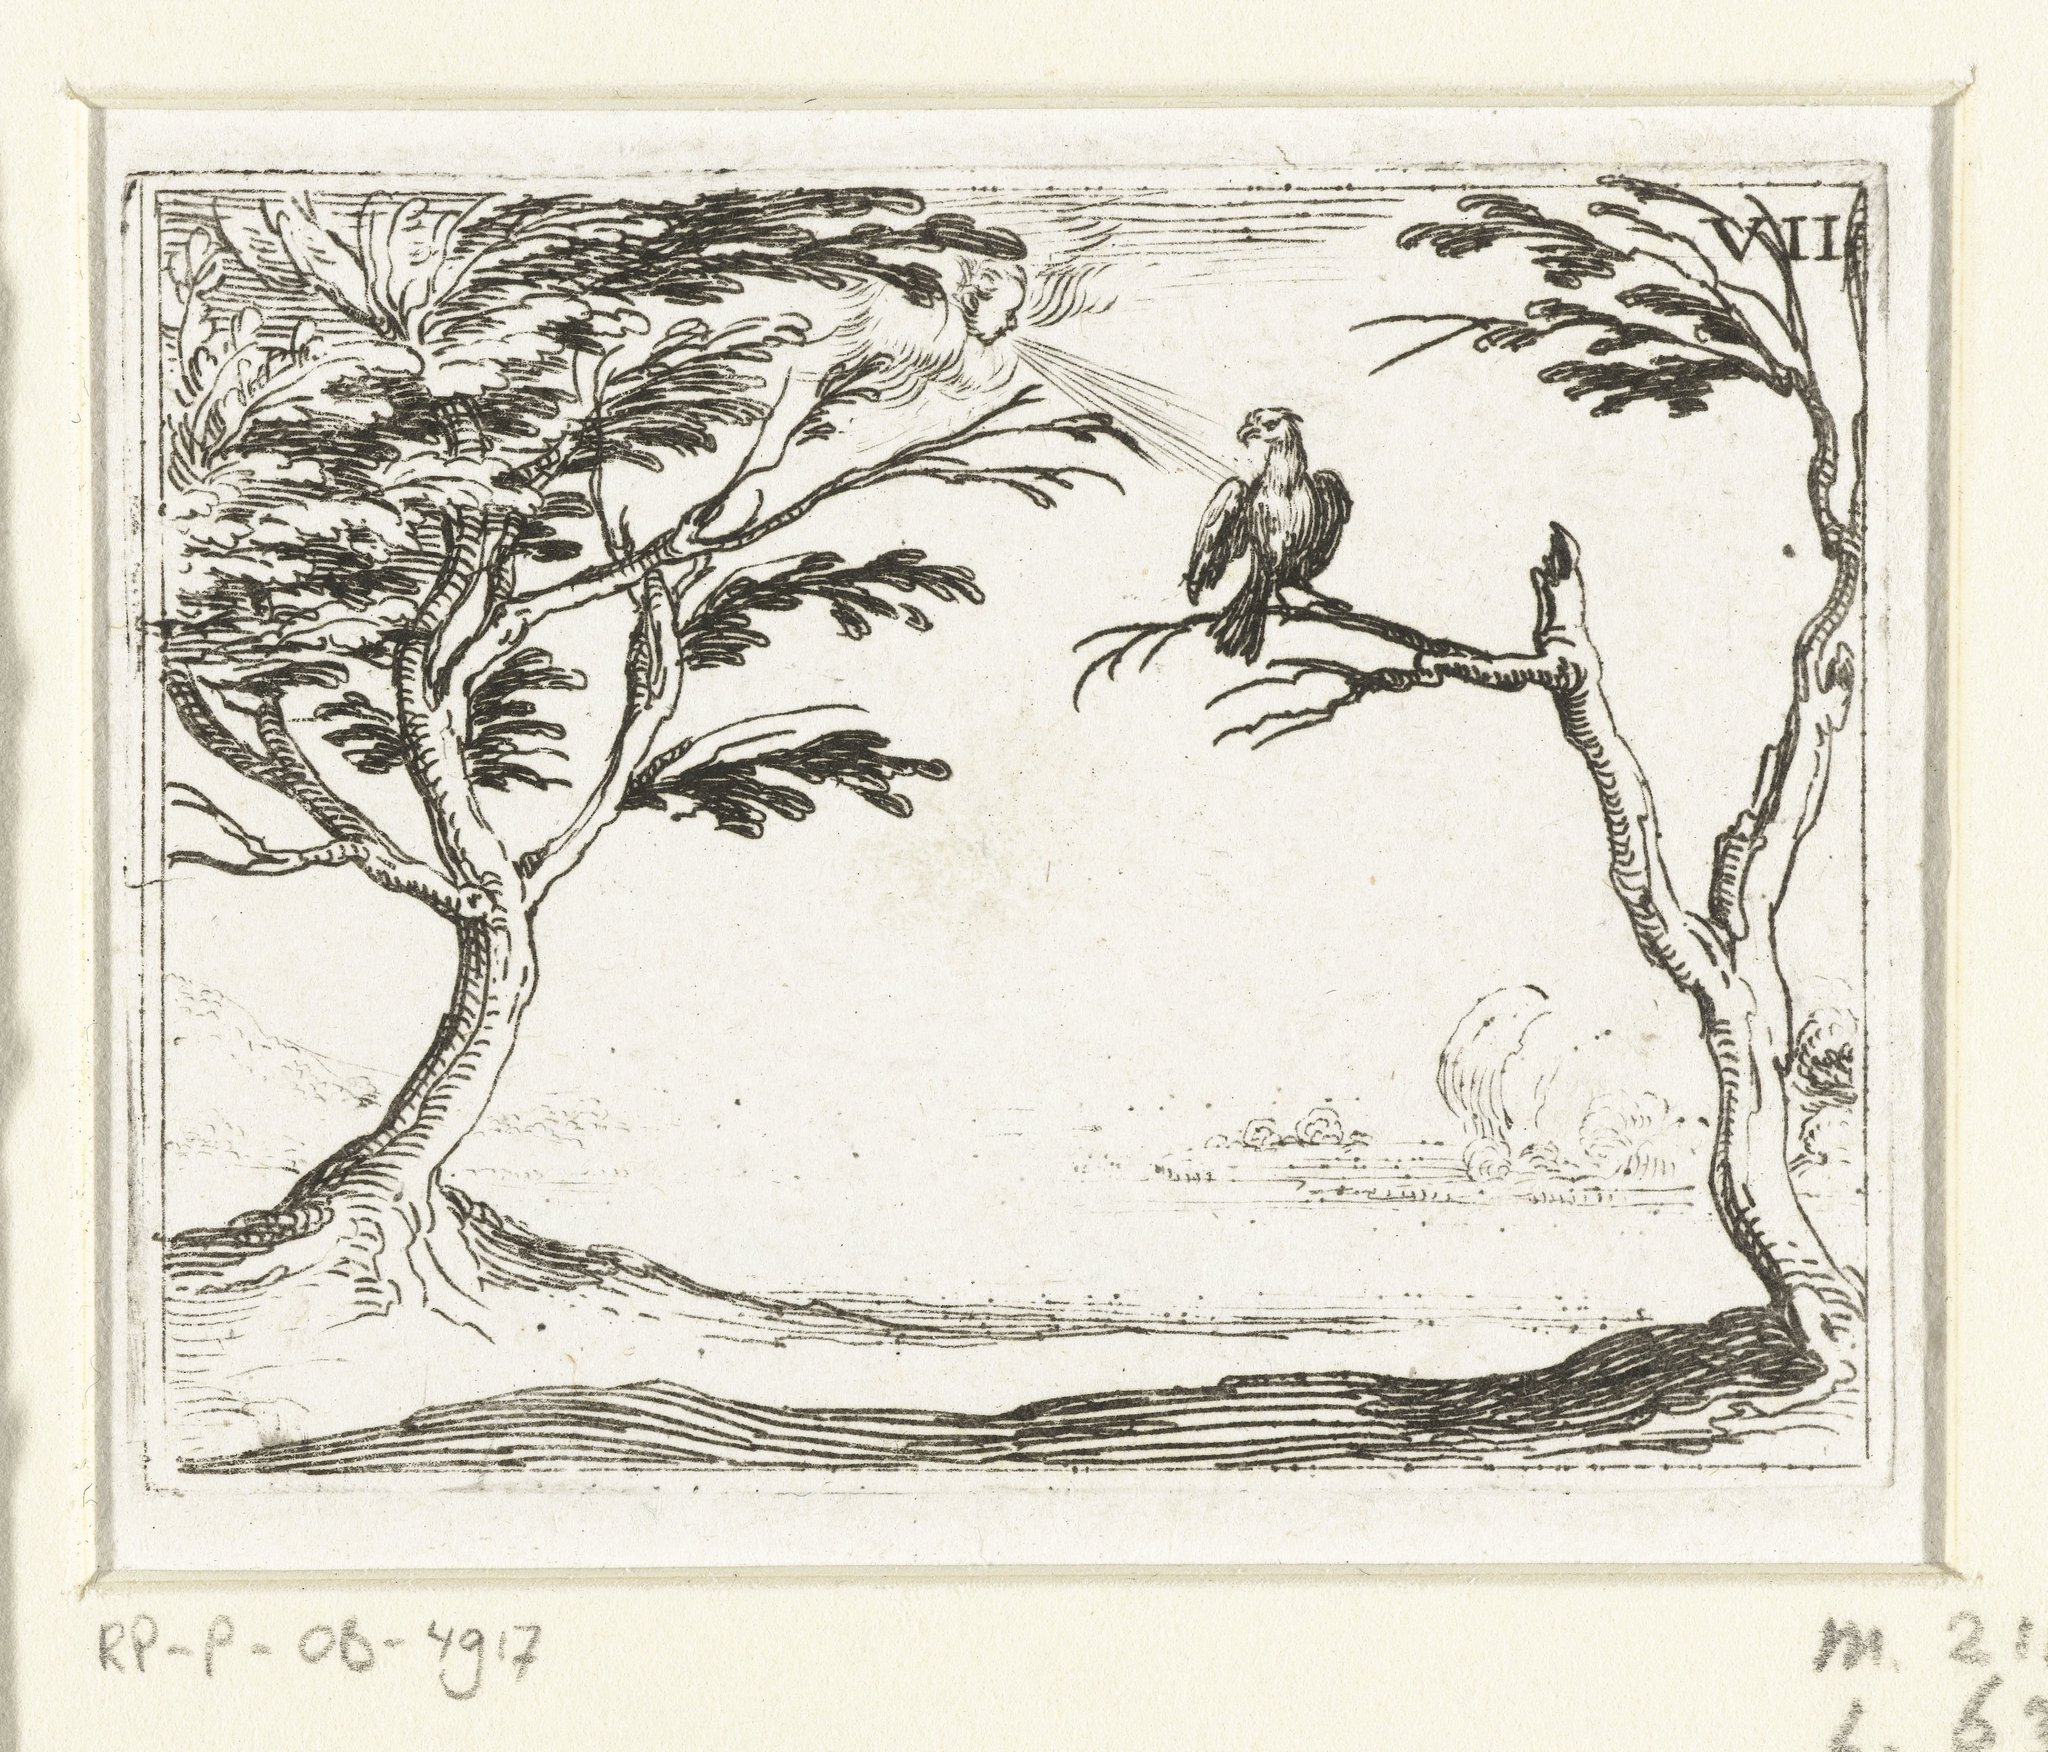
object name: print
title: Leven van Maria in emblemen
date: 1625-1629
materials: paper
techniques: etching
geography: nancy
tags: winds, predatory birds: vulture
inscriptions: collector's mark: Lugt 240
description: Voorstelling van een gier op een boomtak. Een gezichtje in een wolk blaast naar hem. Dit blad is onderdeel van de embleemserie 'Leven van Maria in emblemen'. De eerste staat van deze serie behelst naast een titelpagina en 26 emblemen ook drie bladen met lofzangen op Maria in boekdruk zonder afbeelding.